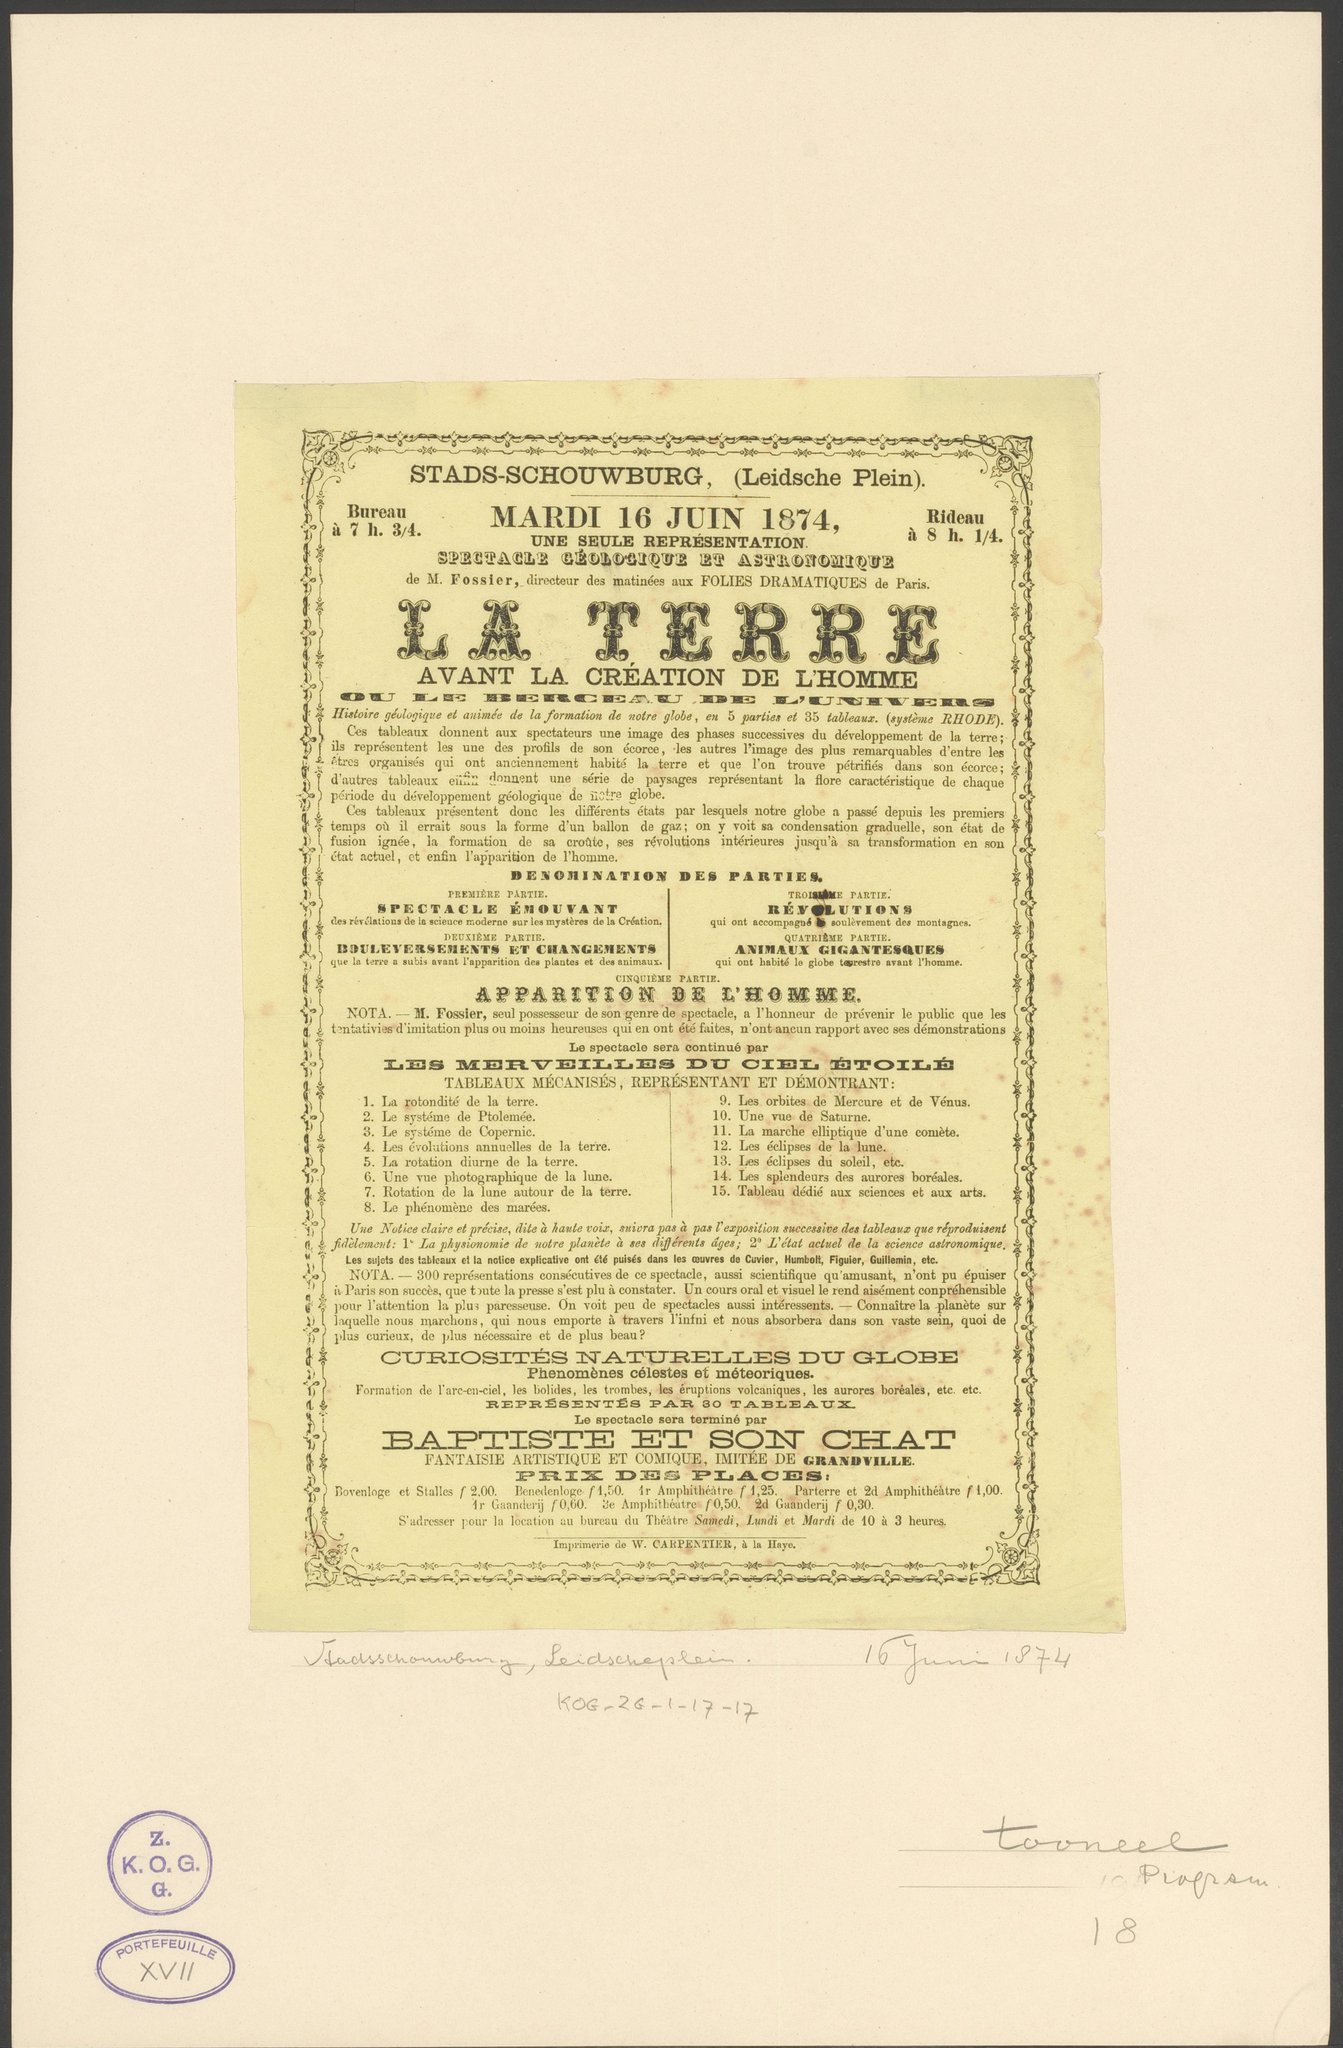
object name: text sheet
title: Aankondiging voor de voorstelling La Terre in de Stadsschouwburg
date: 1878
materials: paper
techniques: letterpress printing, engraving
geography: the hague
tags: theatre, theatrical performance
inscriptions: stamp, collector's mark: Lugt 1641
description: Aankondiging voor de voorstelling La Terre avant la création de l'homme in de Stadsschouwburg. Onder de aankondiging een beschrijving van het stuk en de actes van de voorstelling. Onderaan de prijzen voor diverse plaatsen in de schouwburg. Onderwerpsrubrieken binnen de Atlas Zeden en Gewoonten: Tooneel, Toneelprogramma’s.